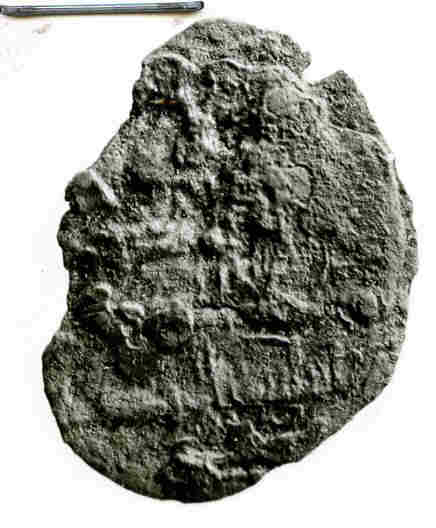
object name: coin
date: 801-833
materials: copper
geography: iran